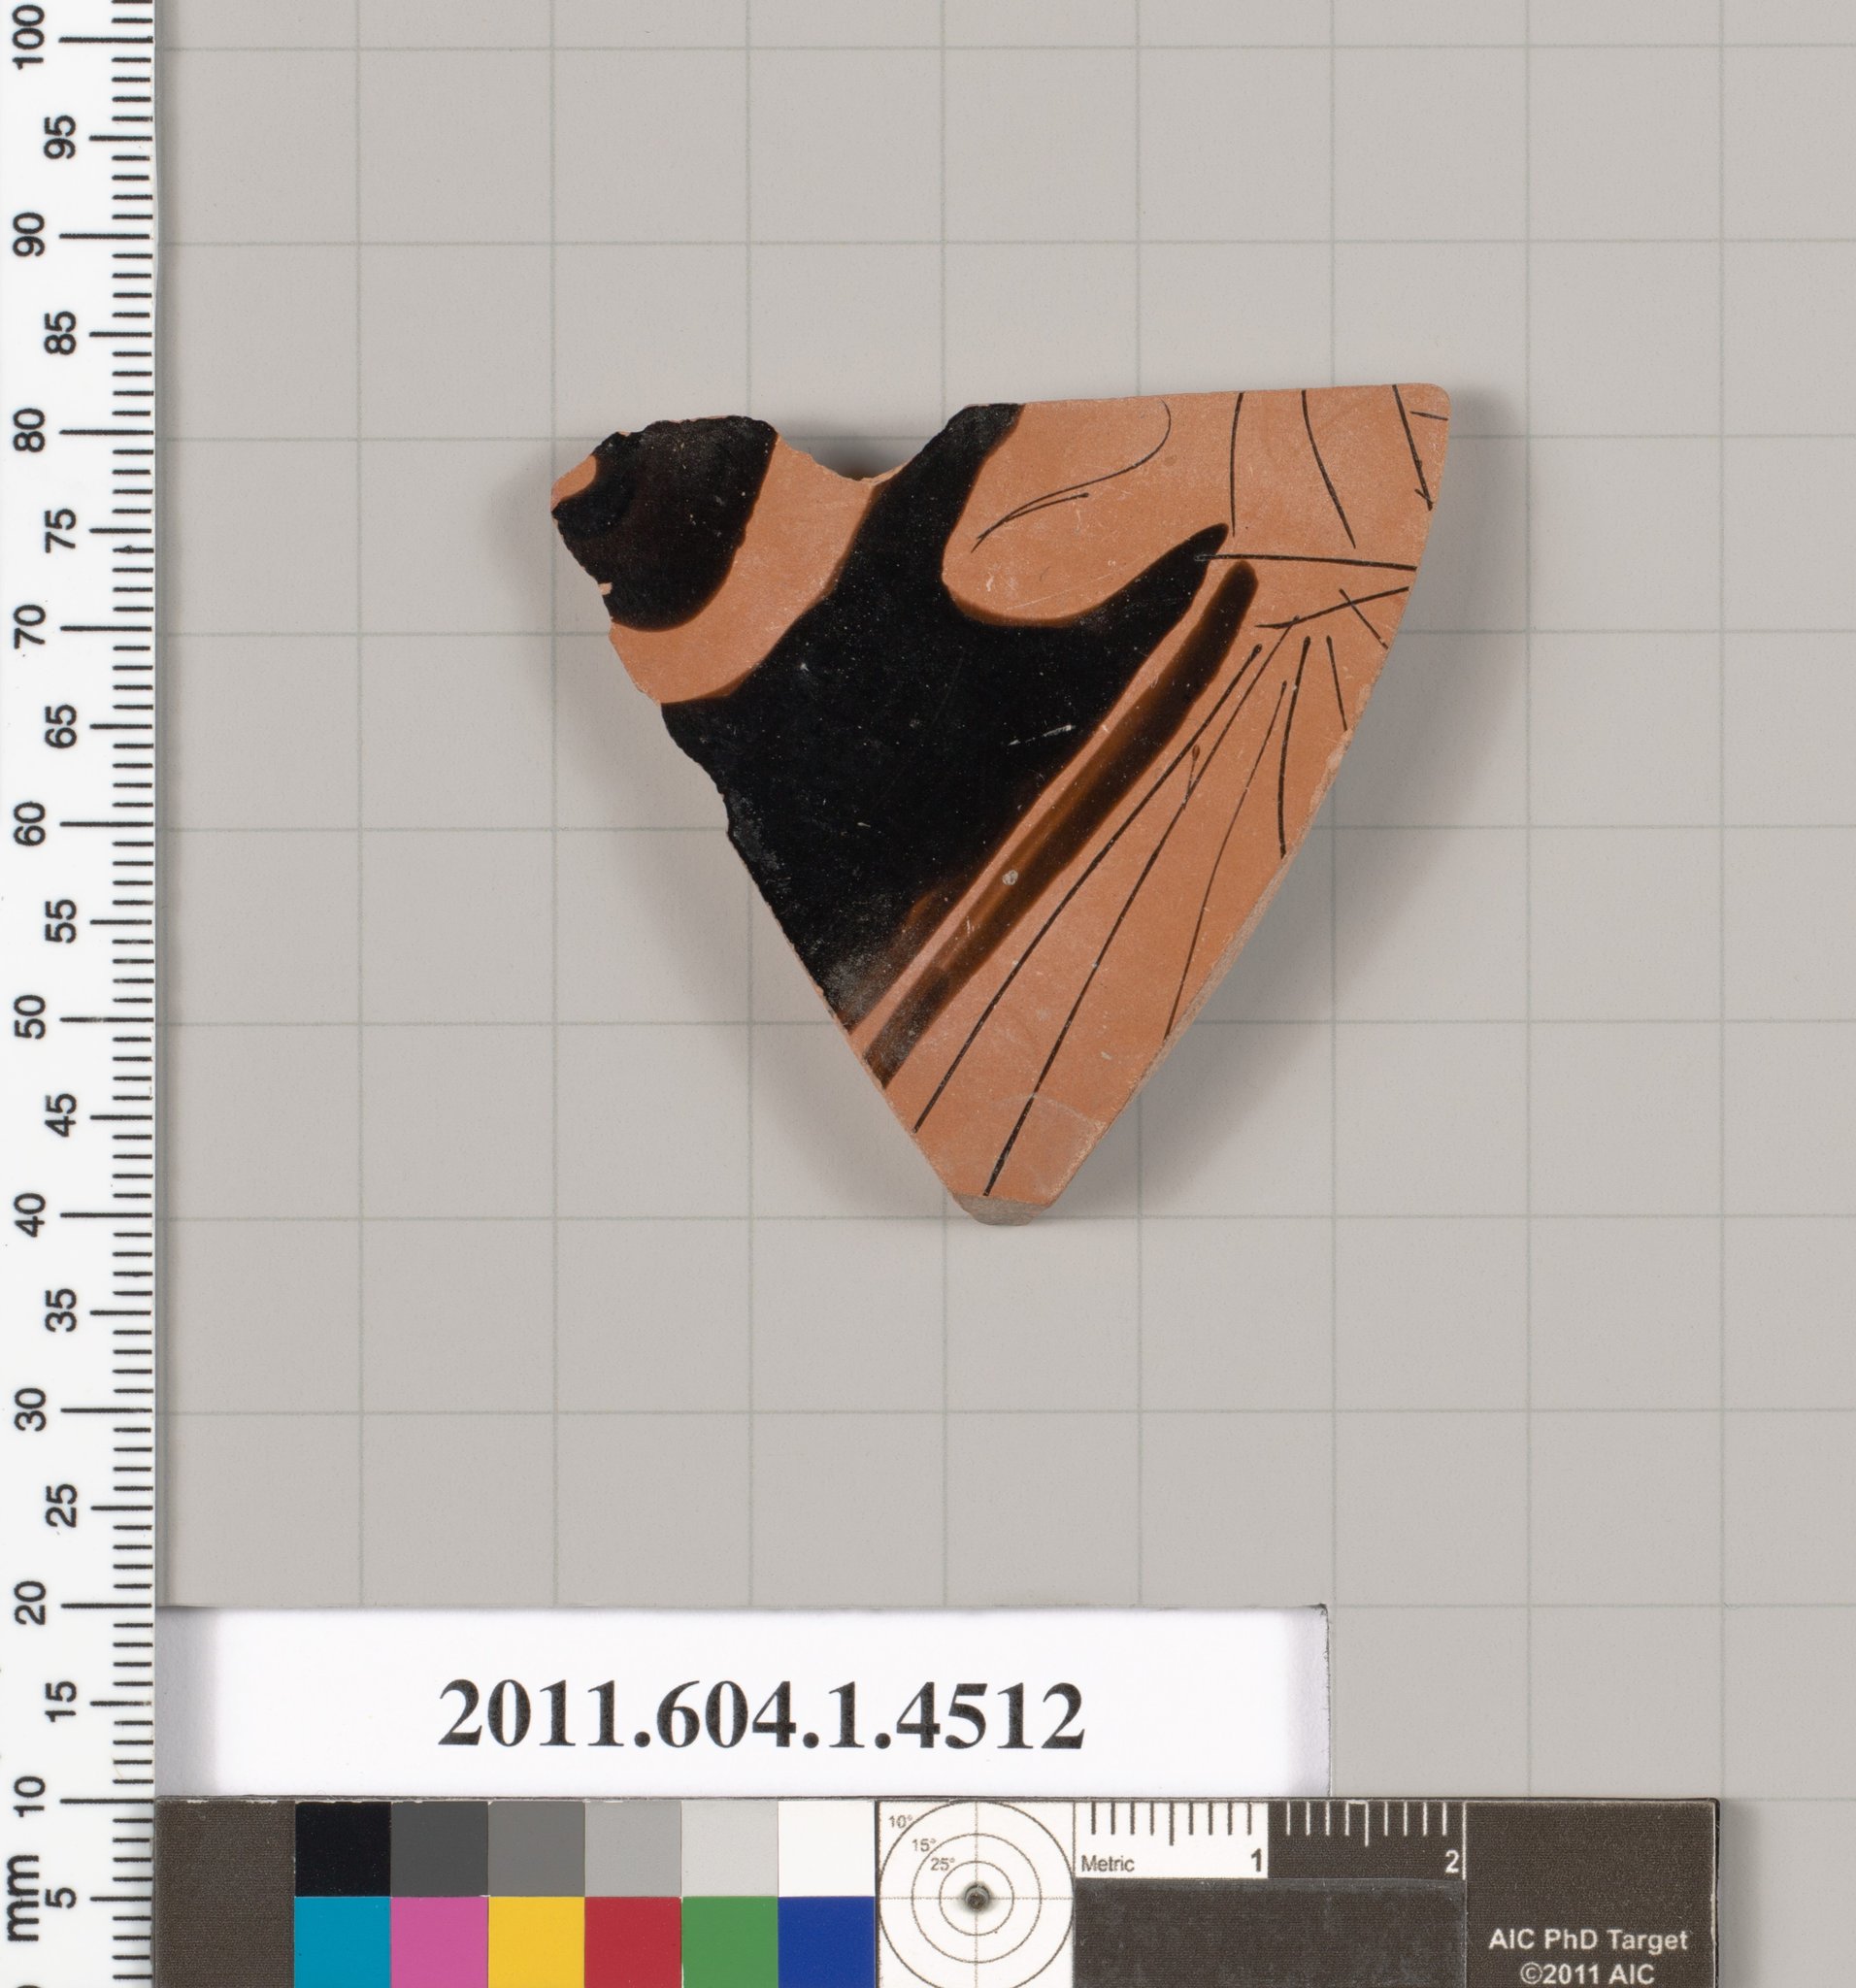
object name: kylix fragment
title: Terracotta fragment of a kylix (drinking cup)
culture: greek, attic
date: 467-435 BCE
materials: terracotta